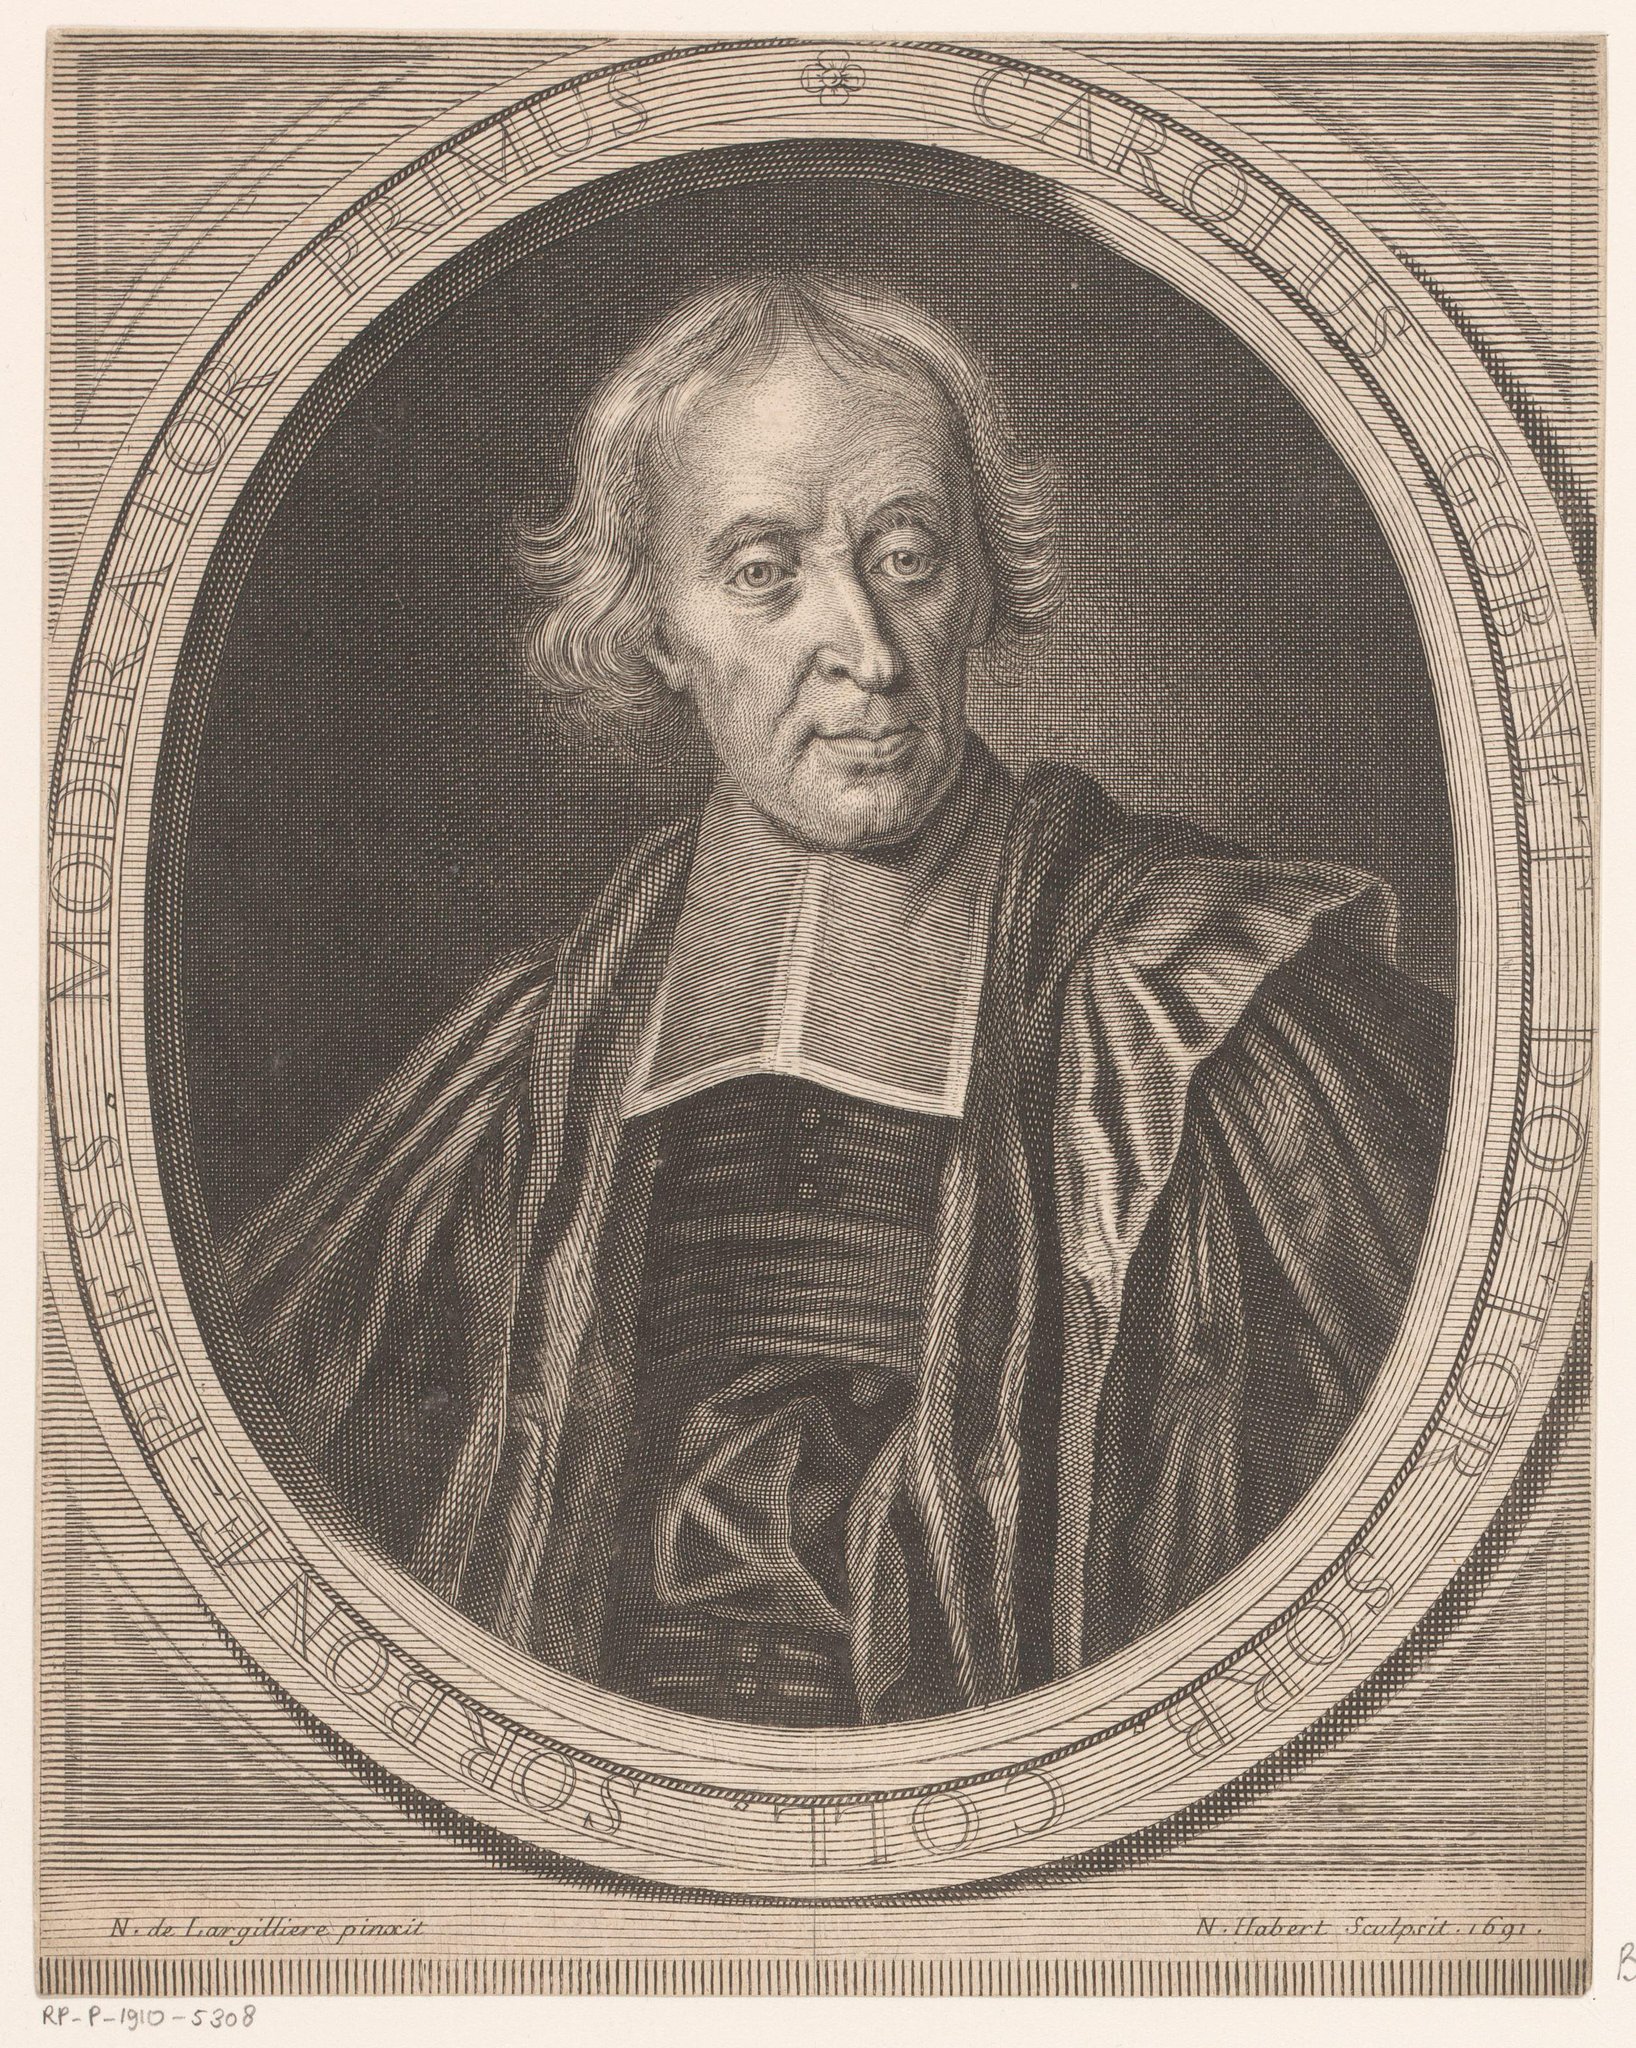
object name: print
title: Portret van Charles Gobinet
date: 1691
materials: paper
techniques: engraving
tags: paris, theologian, historical persons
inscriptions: inscription: ‘E’, collector's mark: Lugt 2228